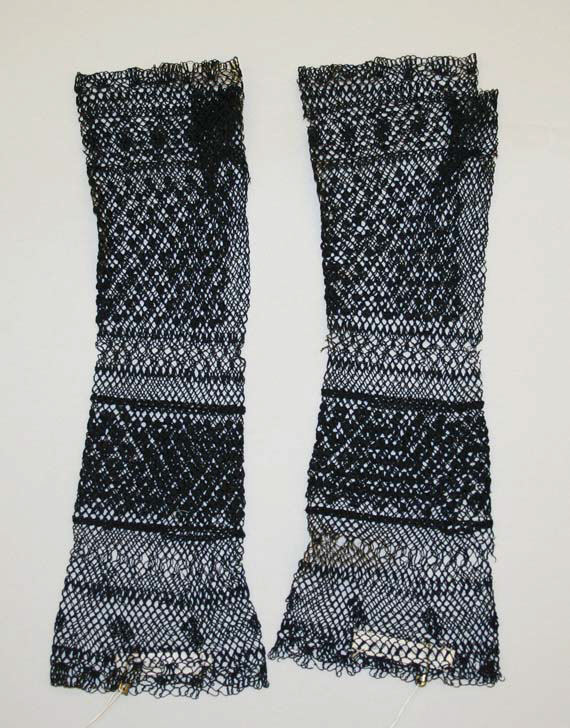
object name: mitt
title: Mitts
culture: american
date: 1870-1879